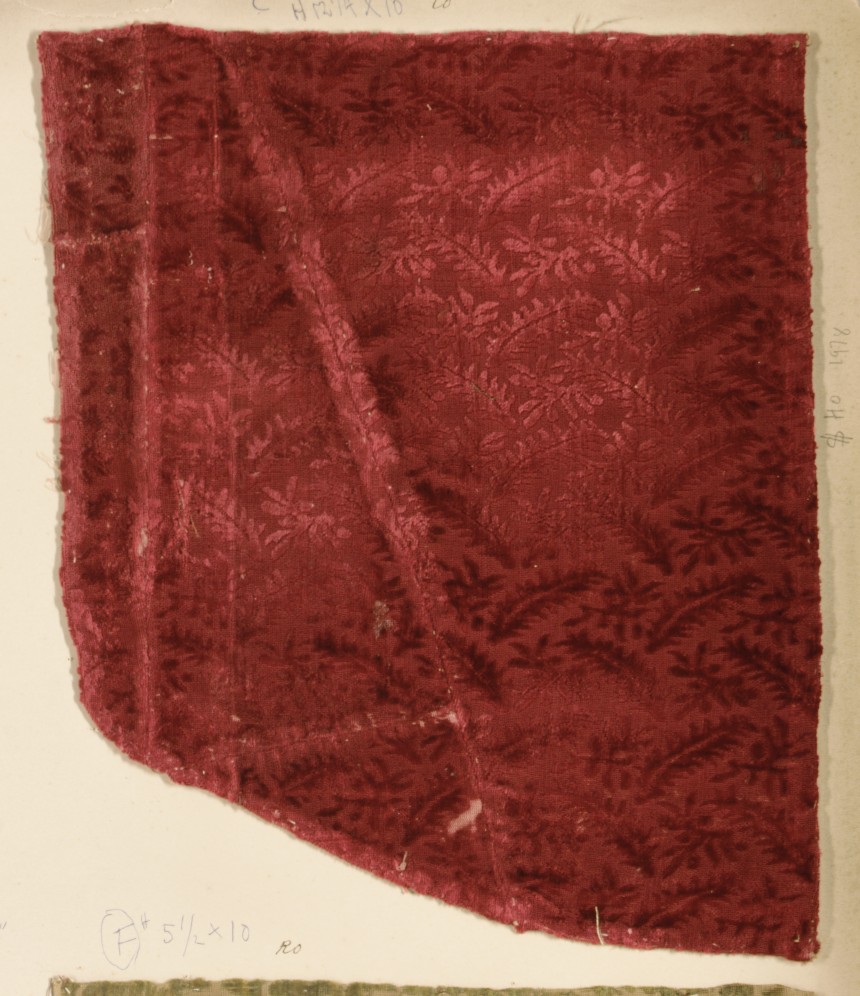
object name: fragment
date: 1501-1600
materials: silk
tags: leaves